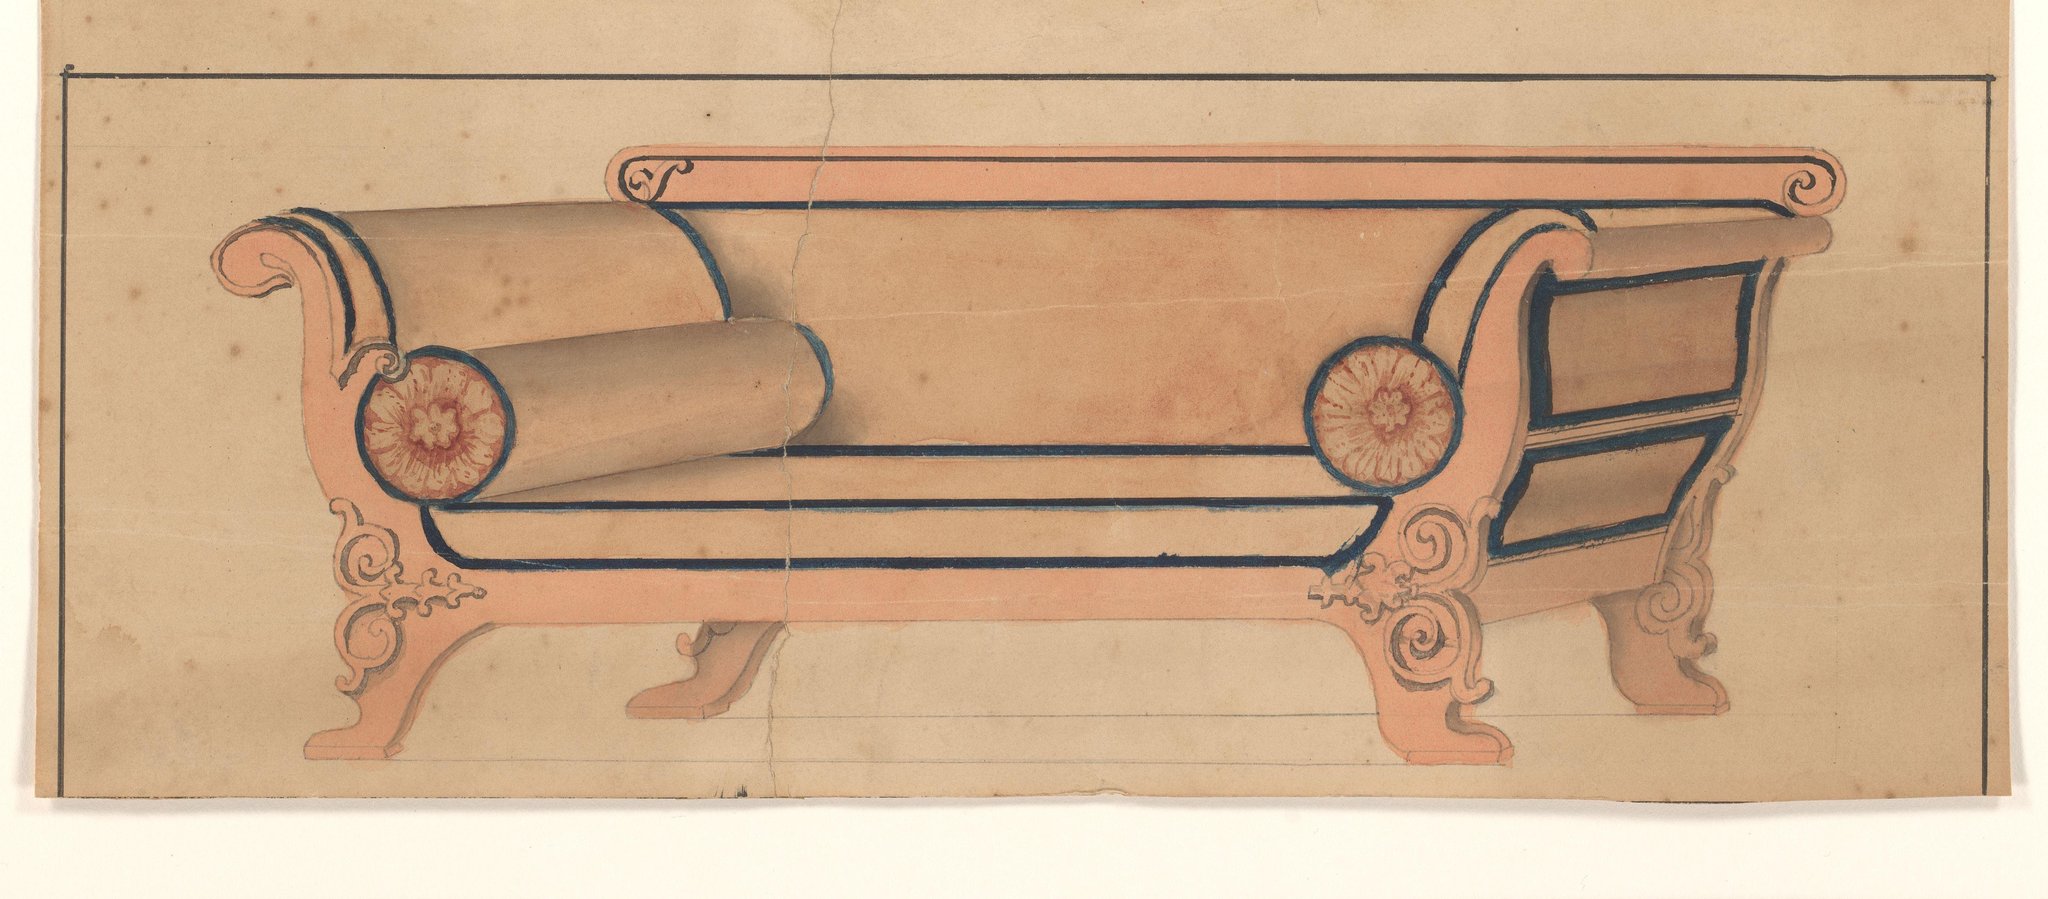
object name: design drawing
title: Ontwerp voor een canapé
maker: Anonymous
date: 1840-1850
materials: ink, paper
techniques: brush, pen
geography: braunschweig